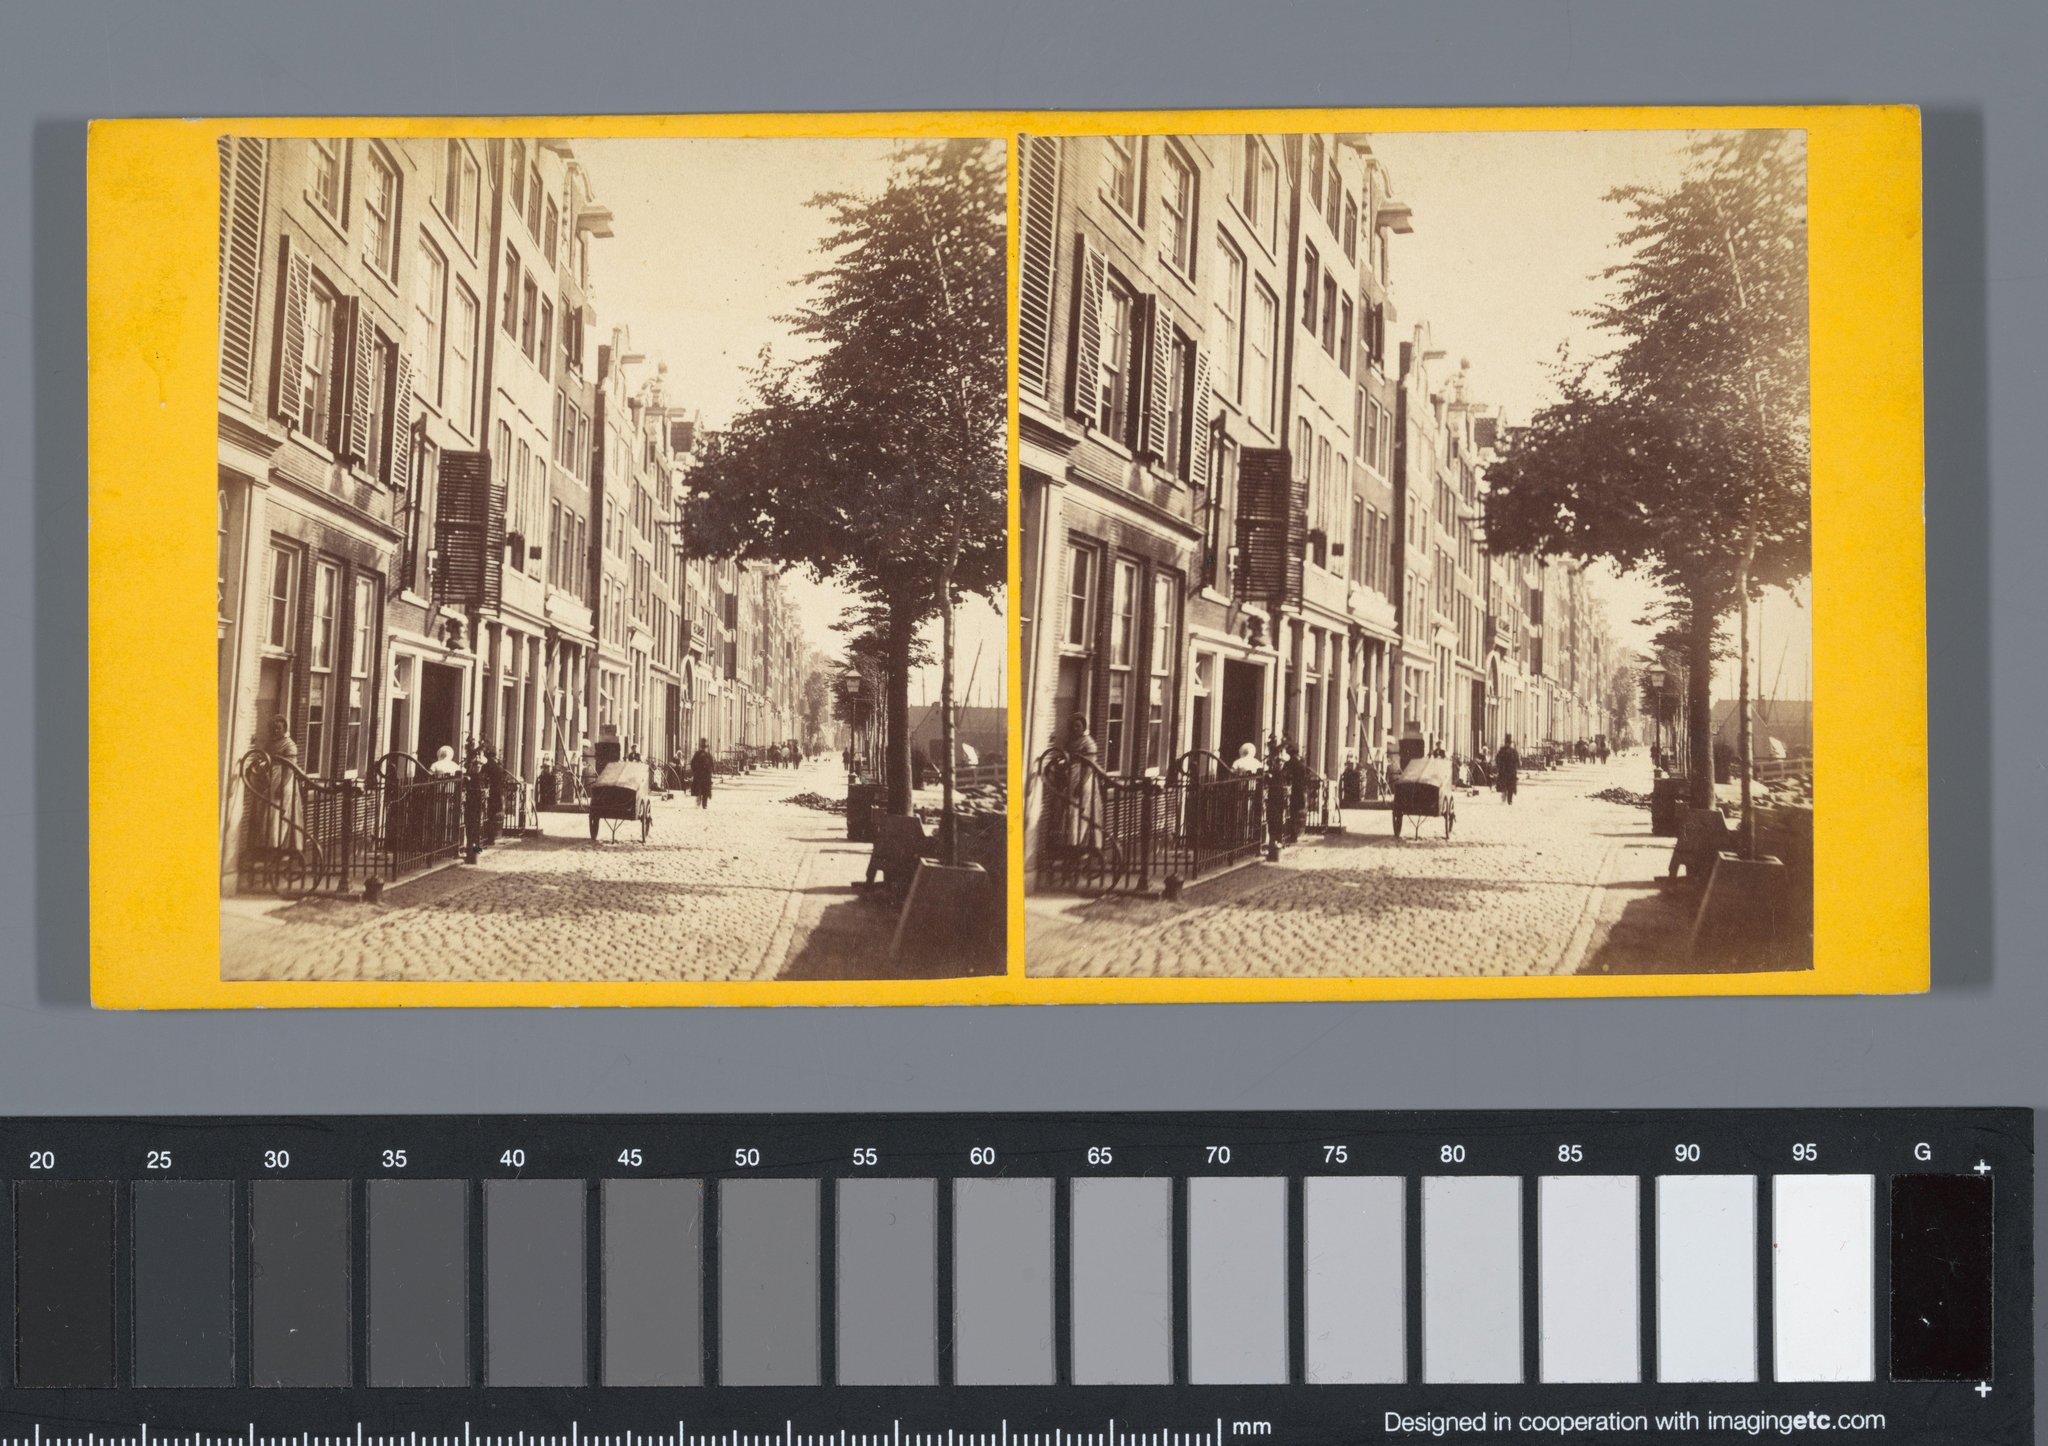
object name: stereograph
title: Het Damrak te Amsterdam met passanten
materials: cardboard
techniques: albumen print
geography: damrak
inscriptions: annotation: ‘Juni 17 in 1867’, label